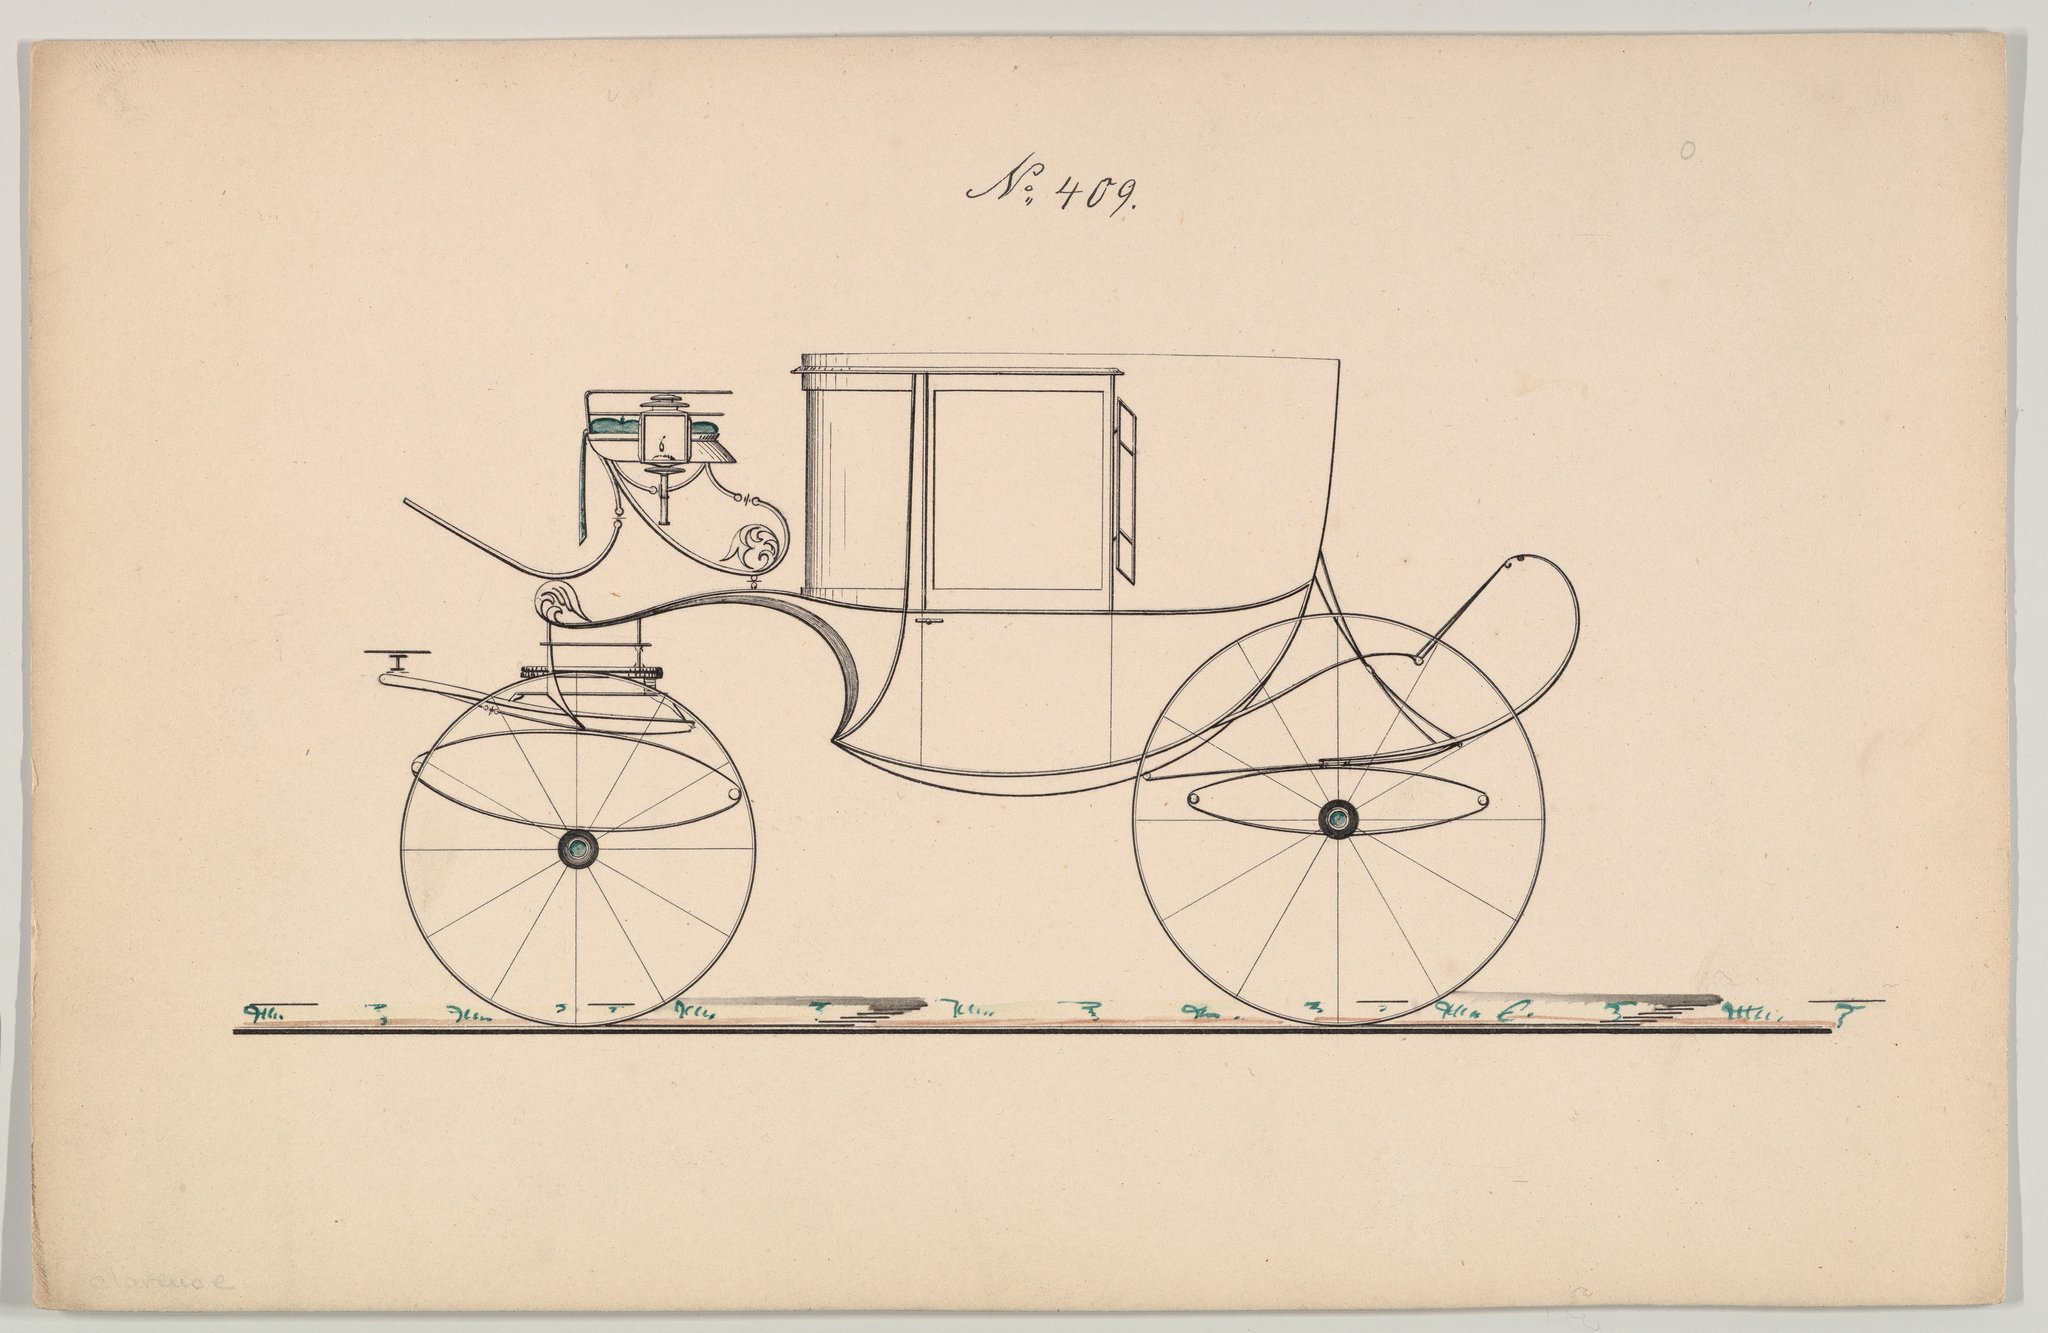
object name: drawing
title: Clarence #409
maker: brewster & co.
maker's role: manufacturer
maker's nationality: american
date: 1850-1870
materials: ink, watercolor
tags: carriages